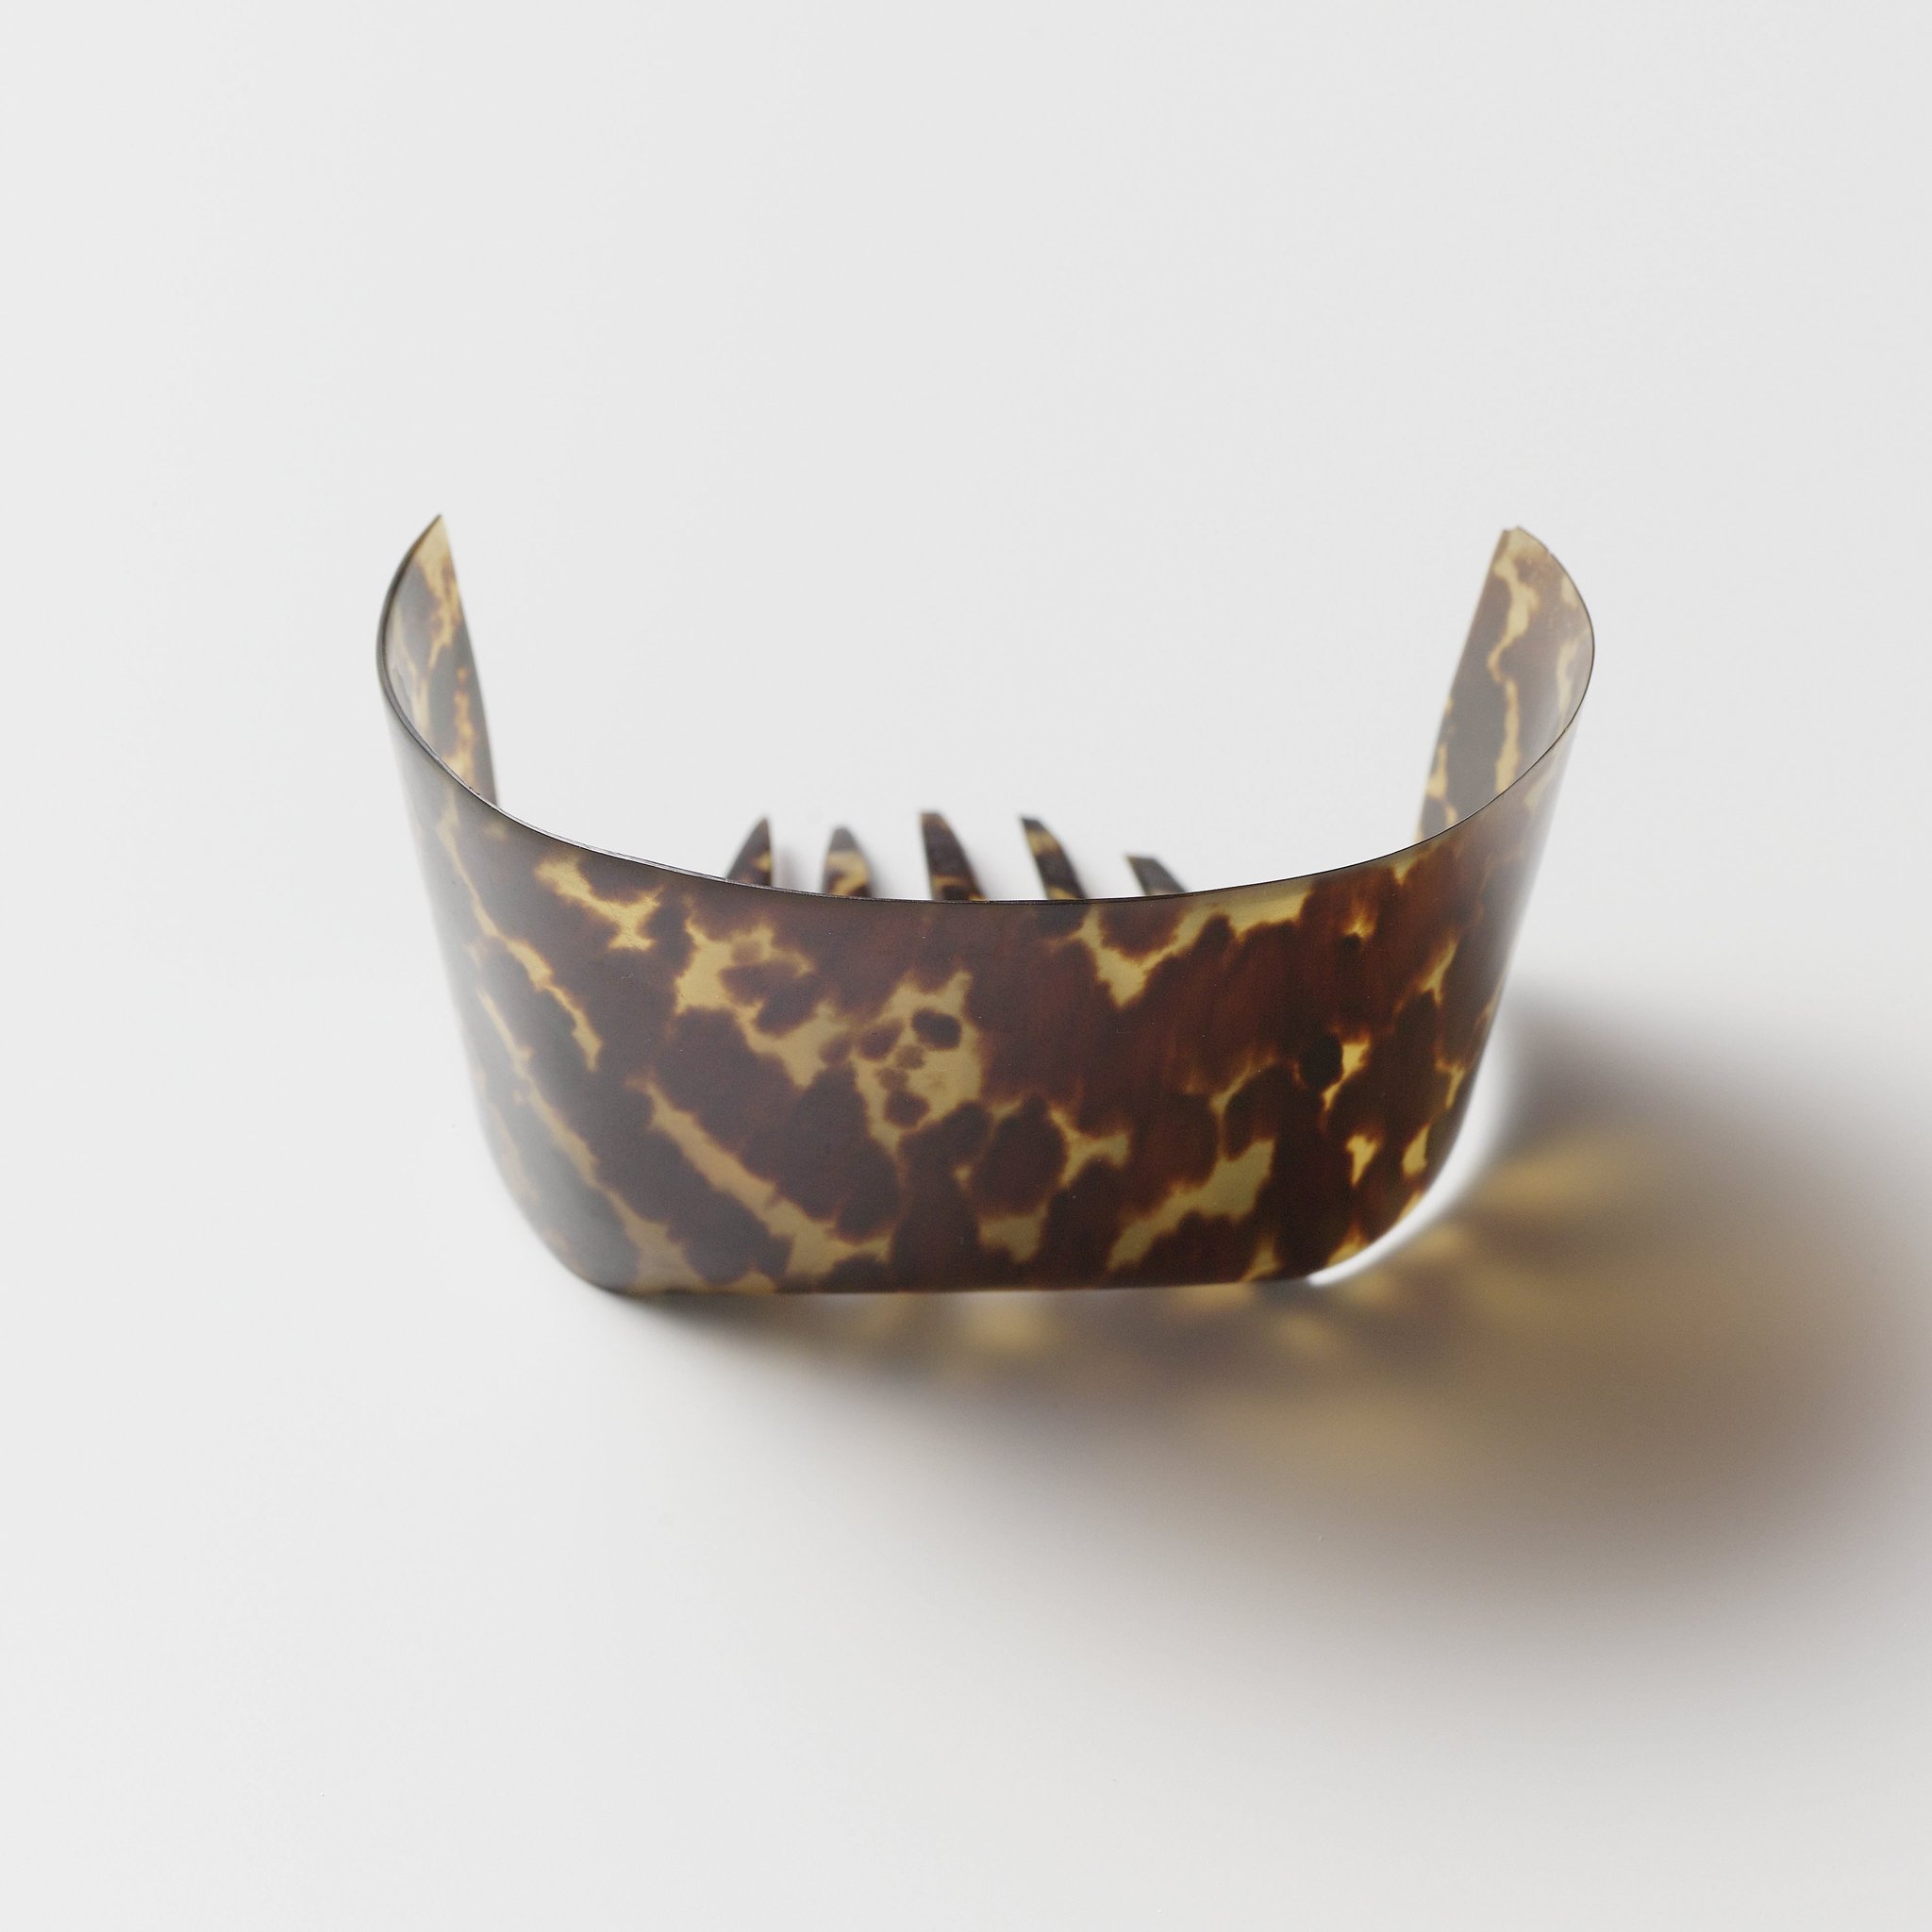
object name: comb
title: Haarkam van imitatie schildpad met vijf tanden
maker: Anonymous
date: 1800-1850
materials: celluloid, plastic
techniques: metalworking, filing, polish, pressing, sawing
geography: europe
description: Een schildpad haarkam met brede randen en vijf tanden.